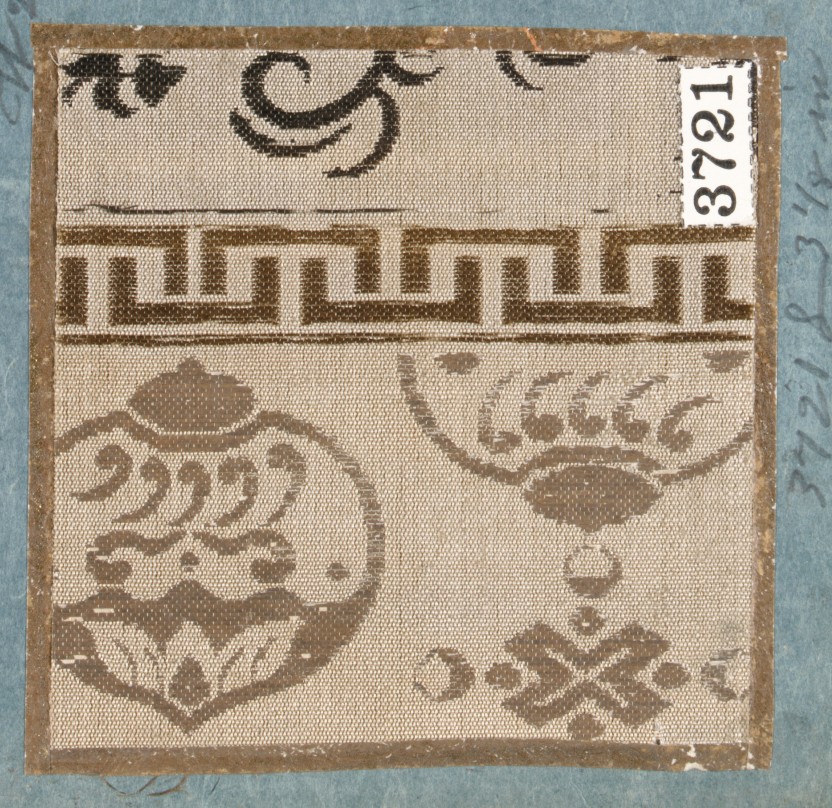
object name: sample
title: Textile Sample from Sample Book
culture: japanese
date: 1801-1900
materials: silk